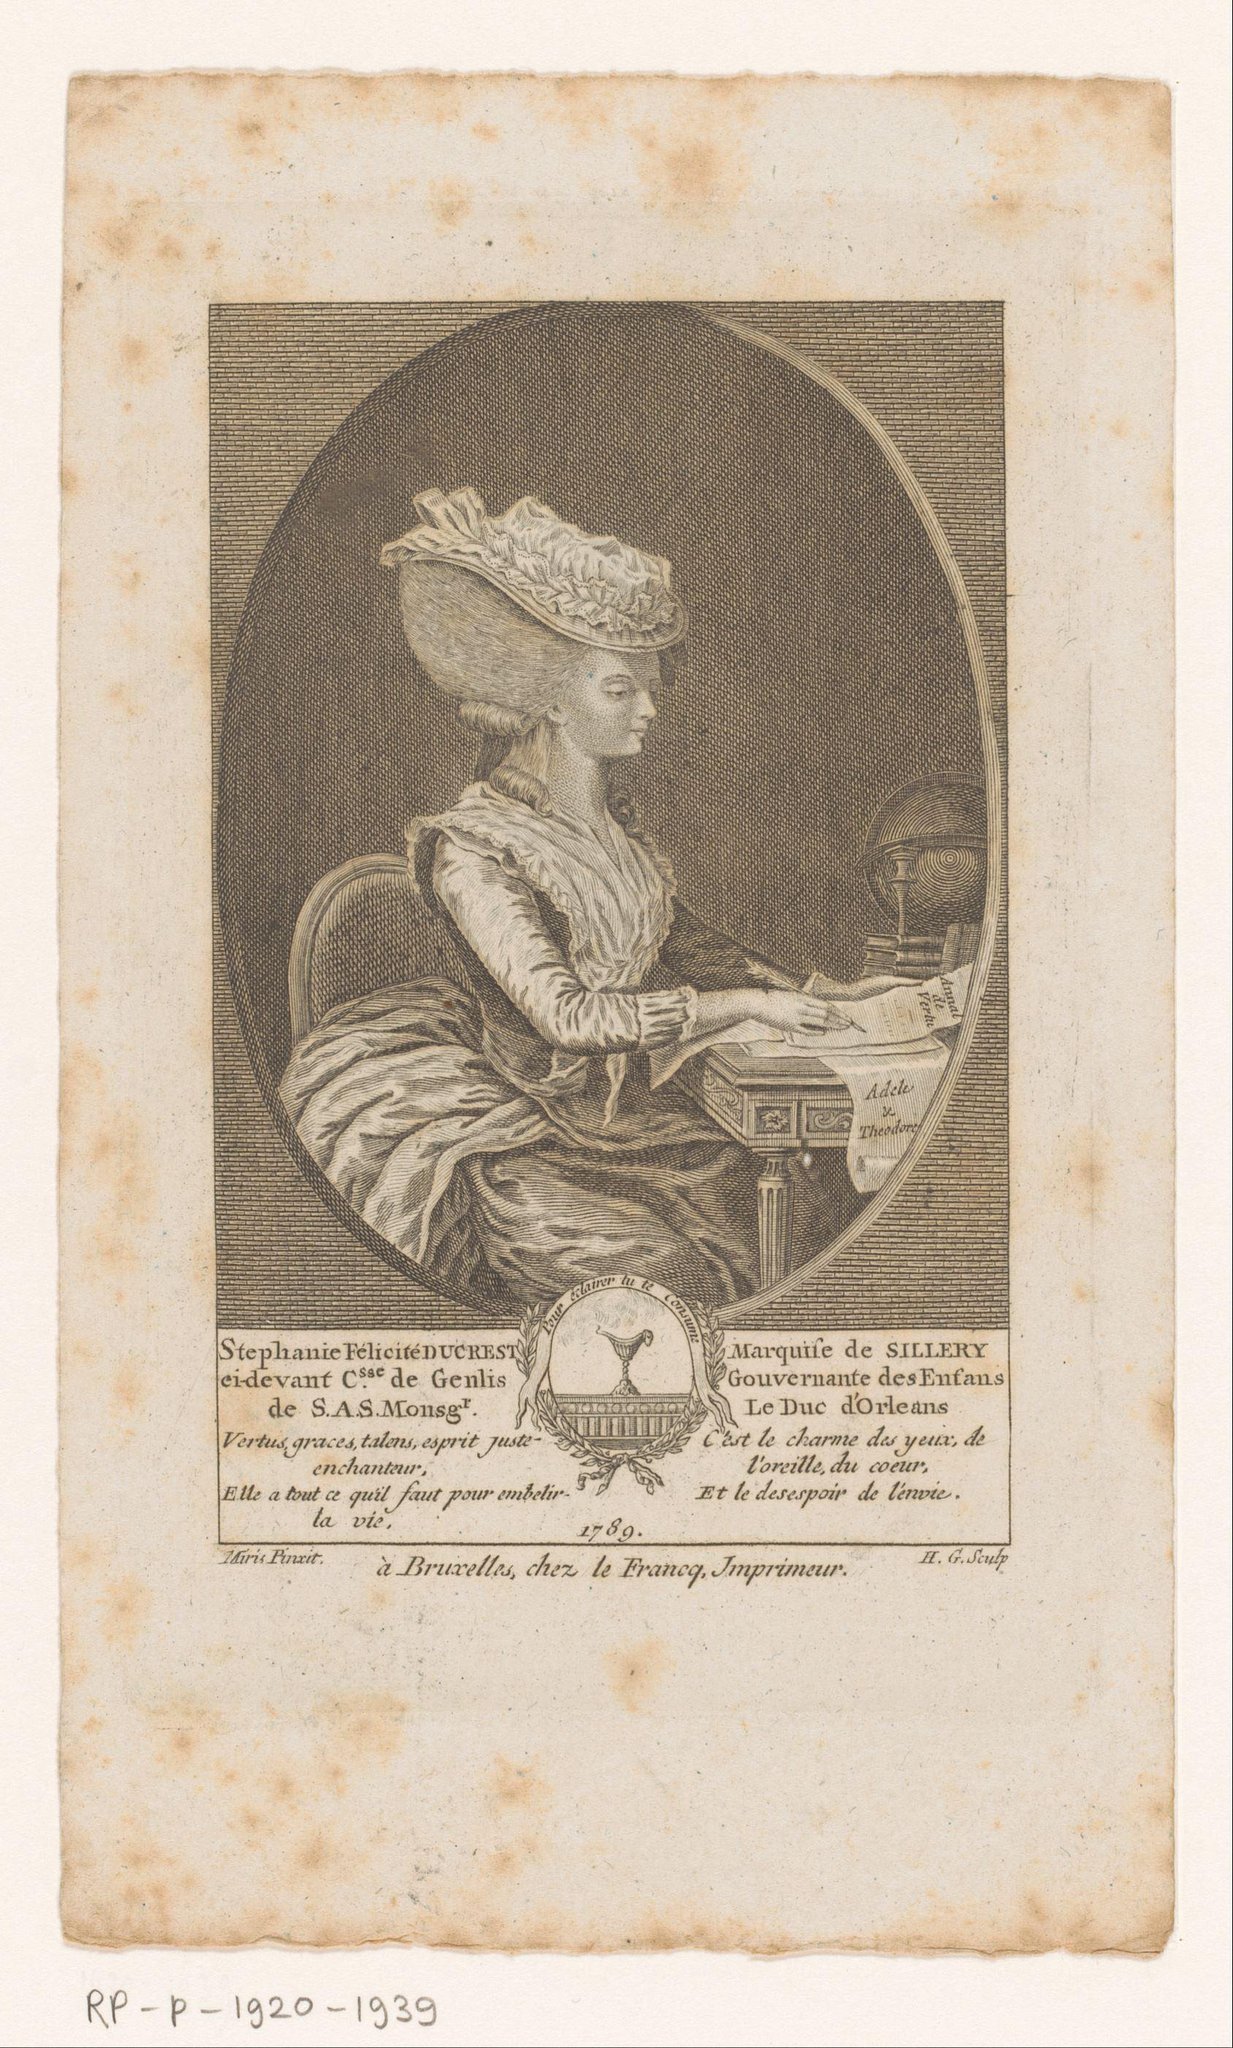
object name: print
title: Portret van Stéphanie Félicité, gravin van Genlis aan een secretaire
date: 1789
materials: paper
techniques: engraving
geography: brussels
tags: paris, writing-table, writing-desk, head-gear, historical persons, clothes, costume (+ women's clothes)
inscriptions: collector's mark: Lugt 2228